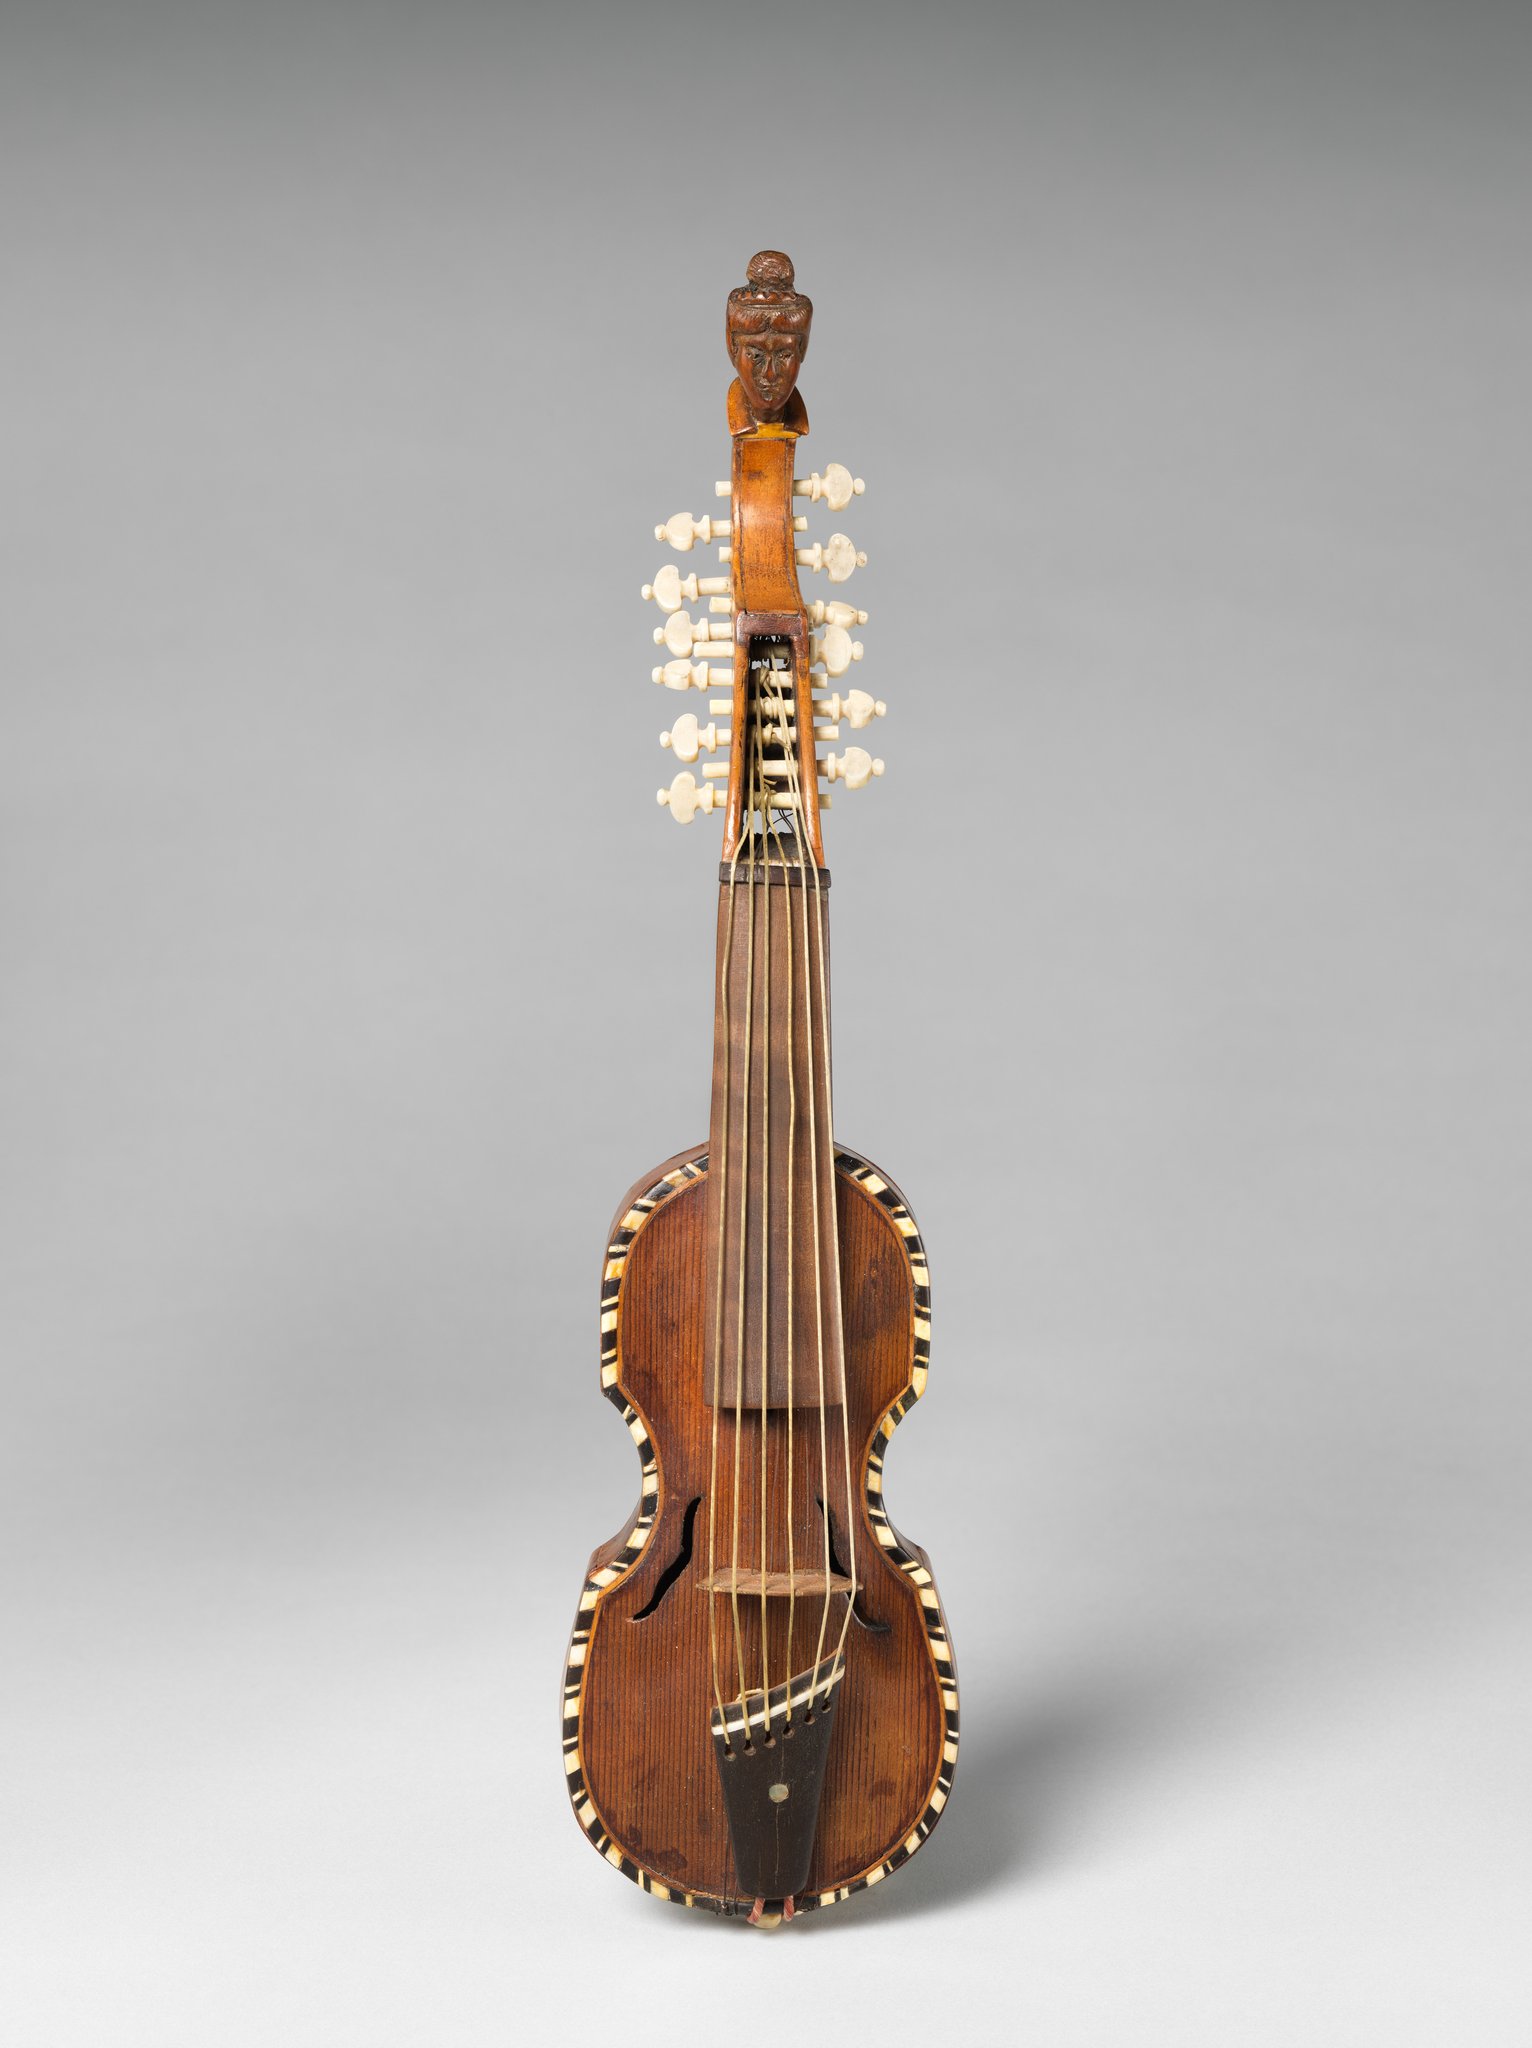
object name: viola d'amore pochette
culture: french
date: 1701-1800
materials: wood, ivory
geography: france